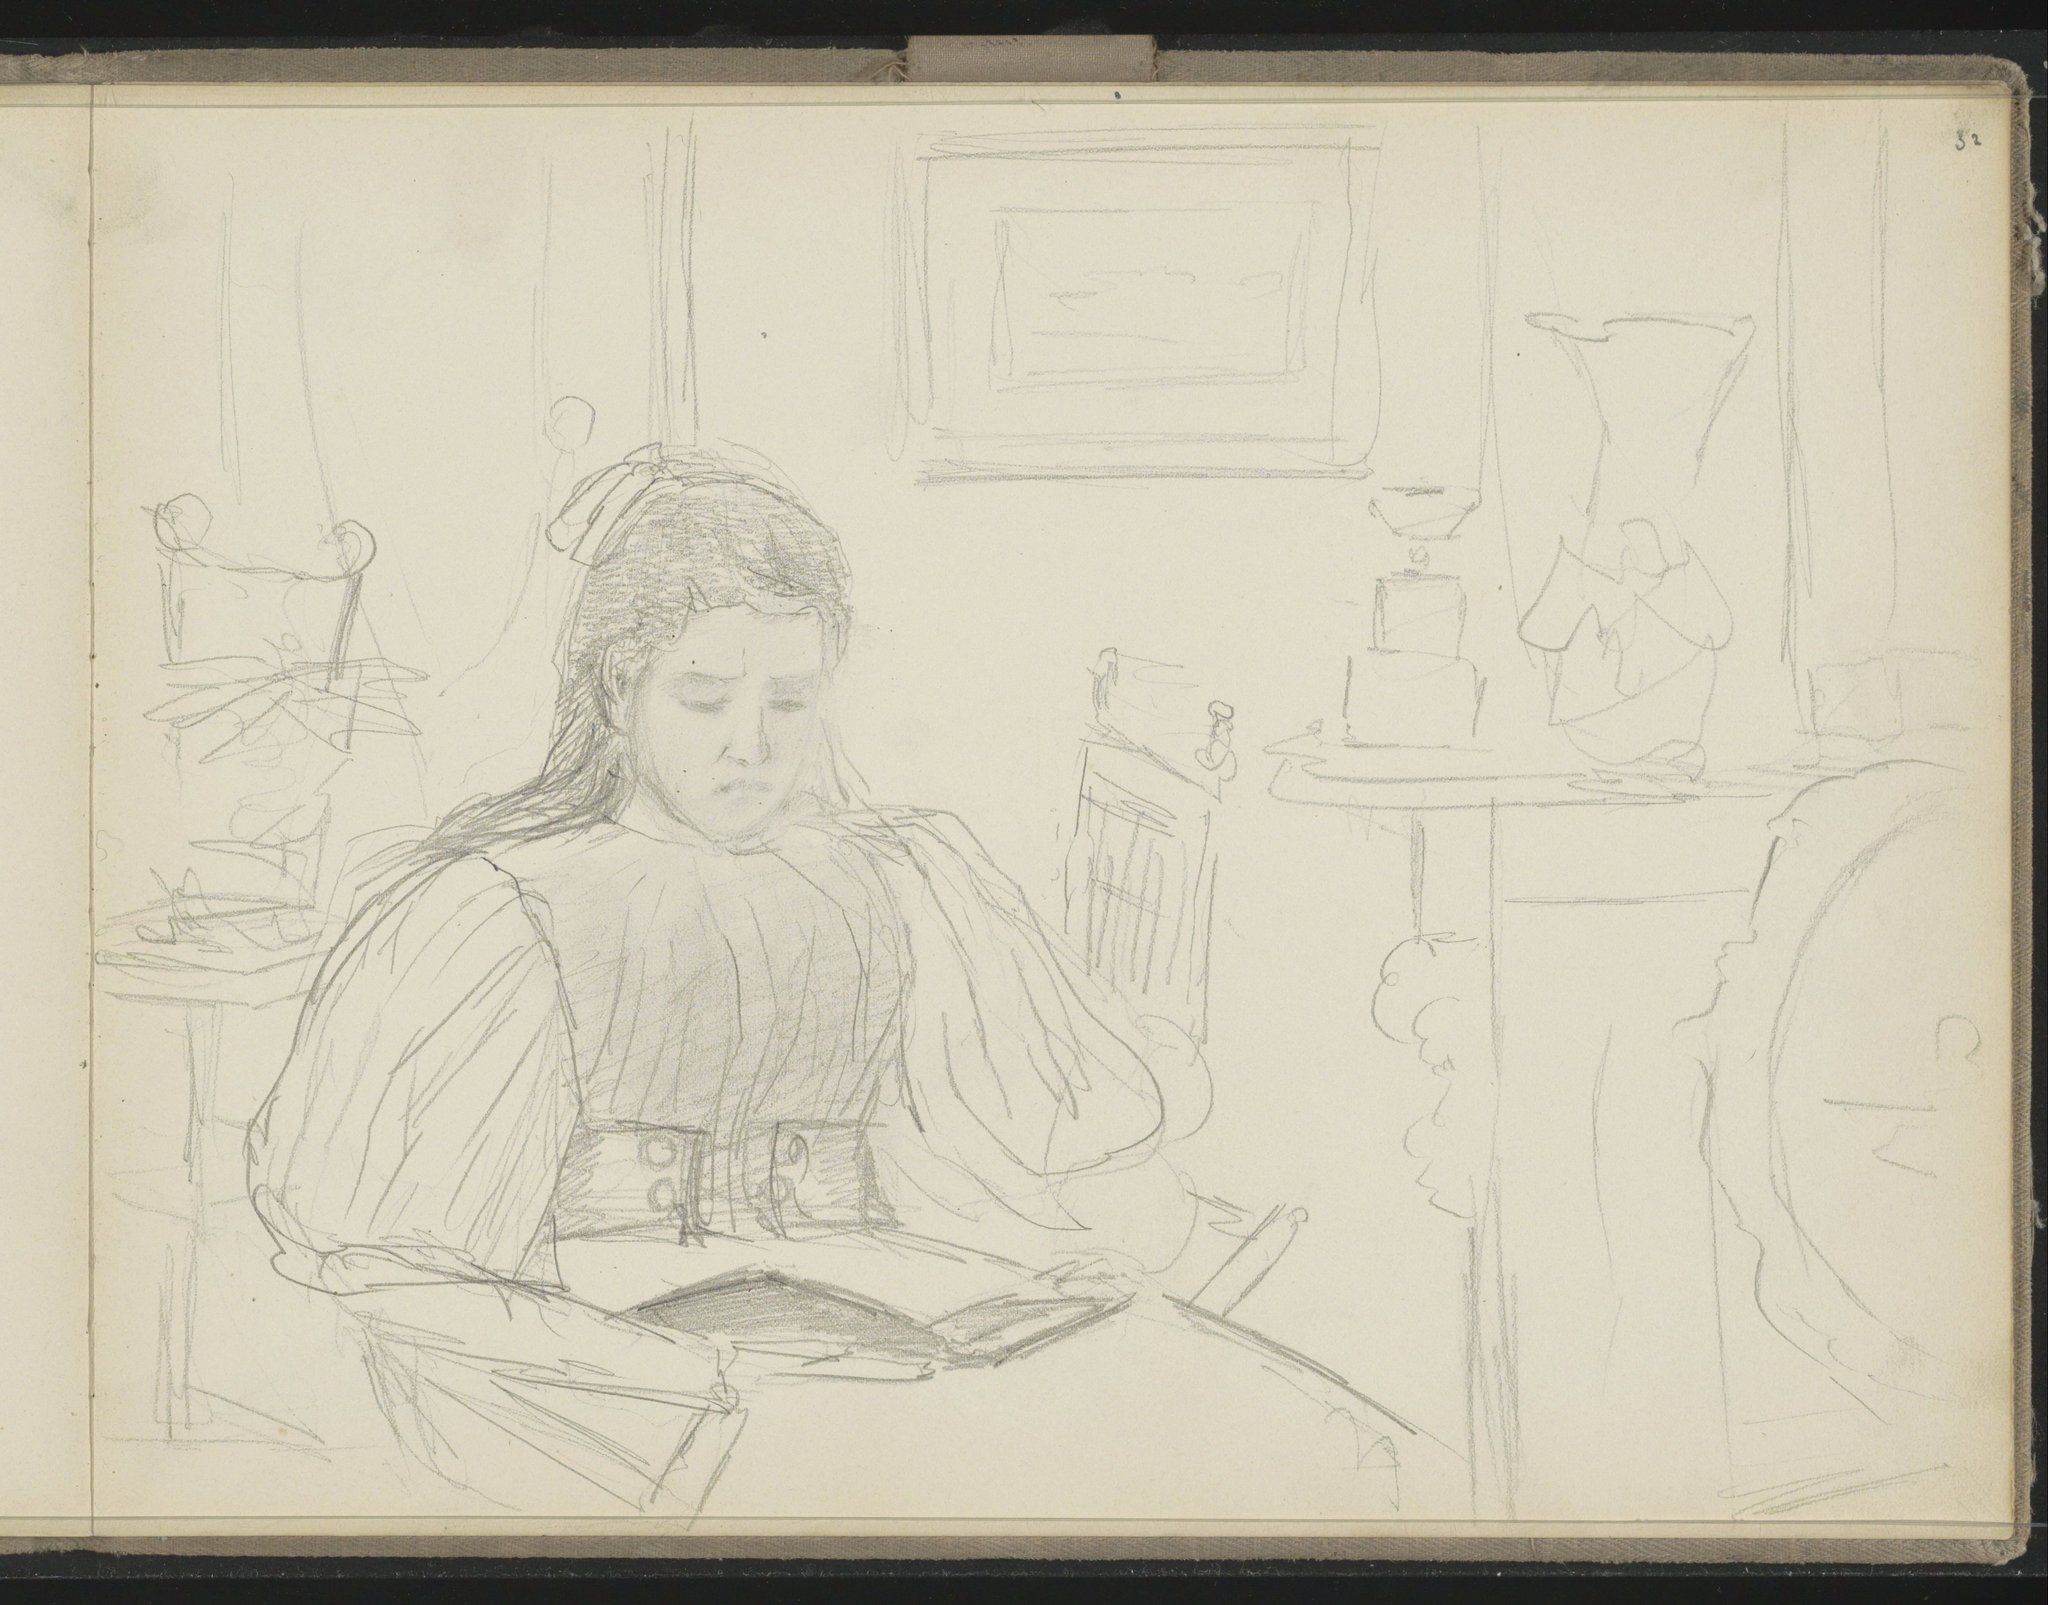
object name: sketchbook leaf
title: Lezend meisje in een interieur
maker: chris huidekooper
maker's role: draughtsman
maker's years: 1878-1939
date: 1895-1896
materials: paper, pencil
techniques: stumping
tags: reading, girl (child between toddler and youth), interior of the house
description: Blad 32 recto uit een schetsboek met 32 bladen.